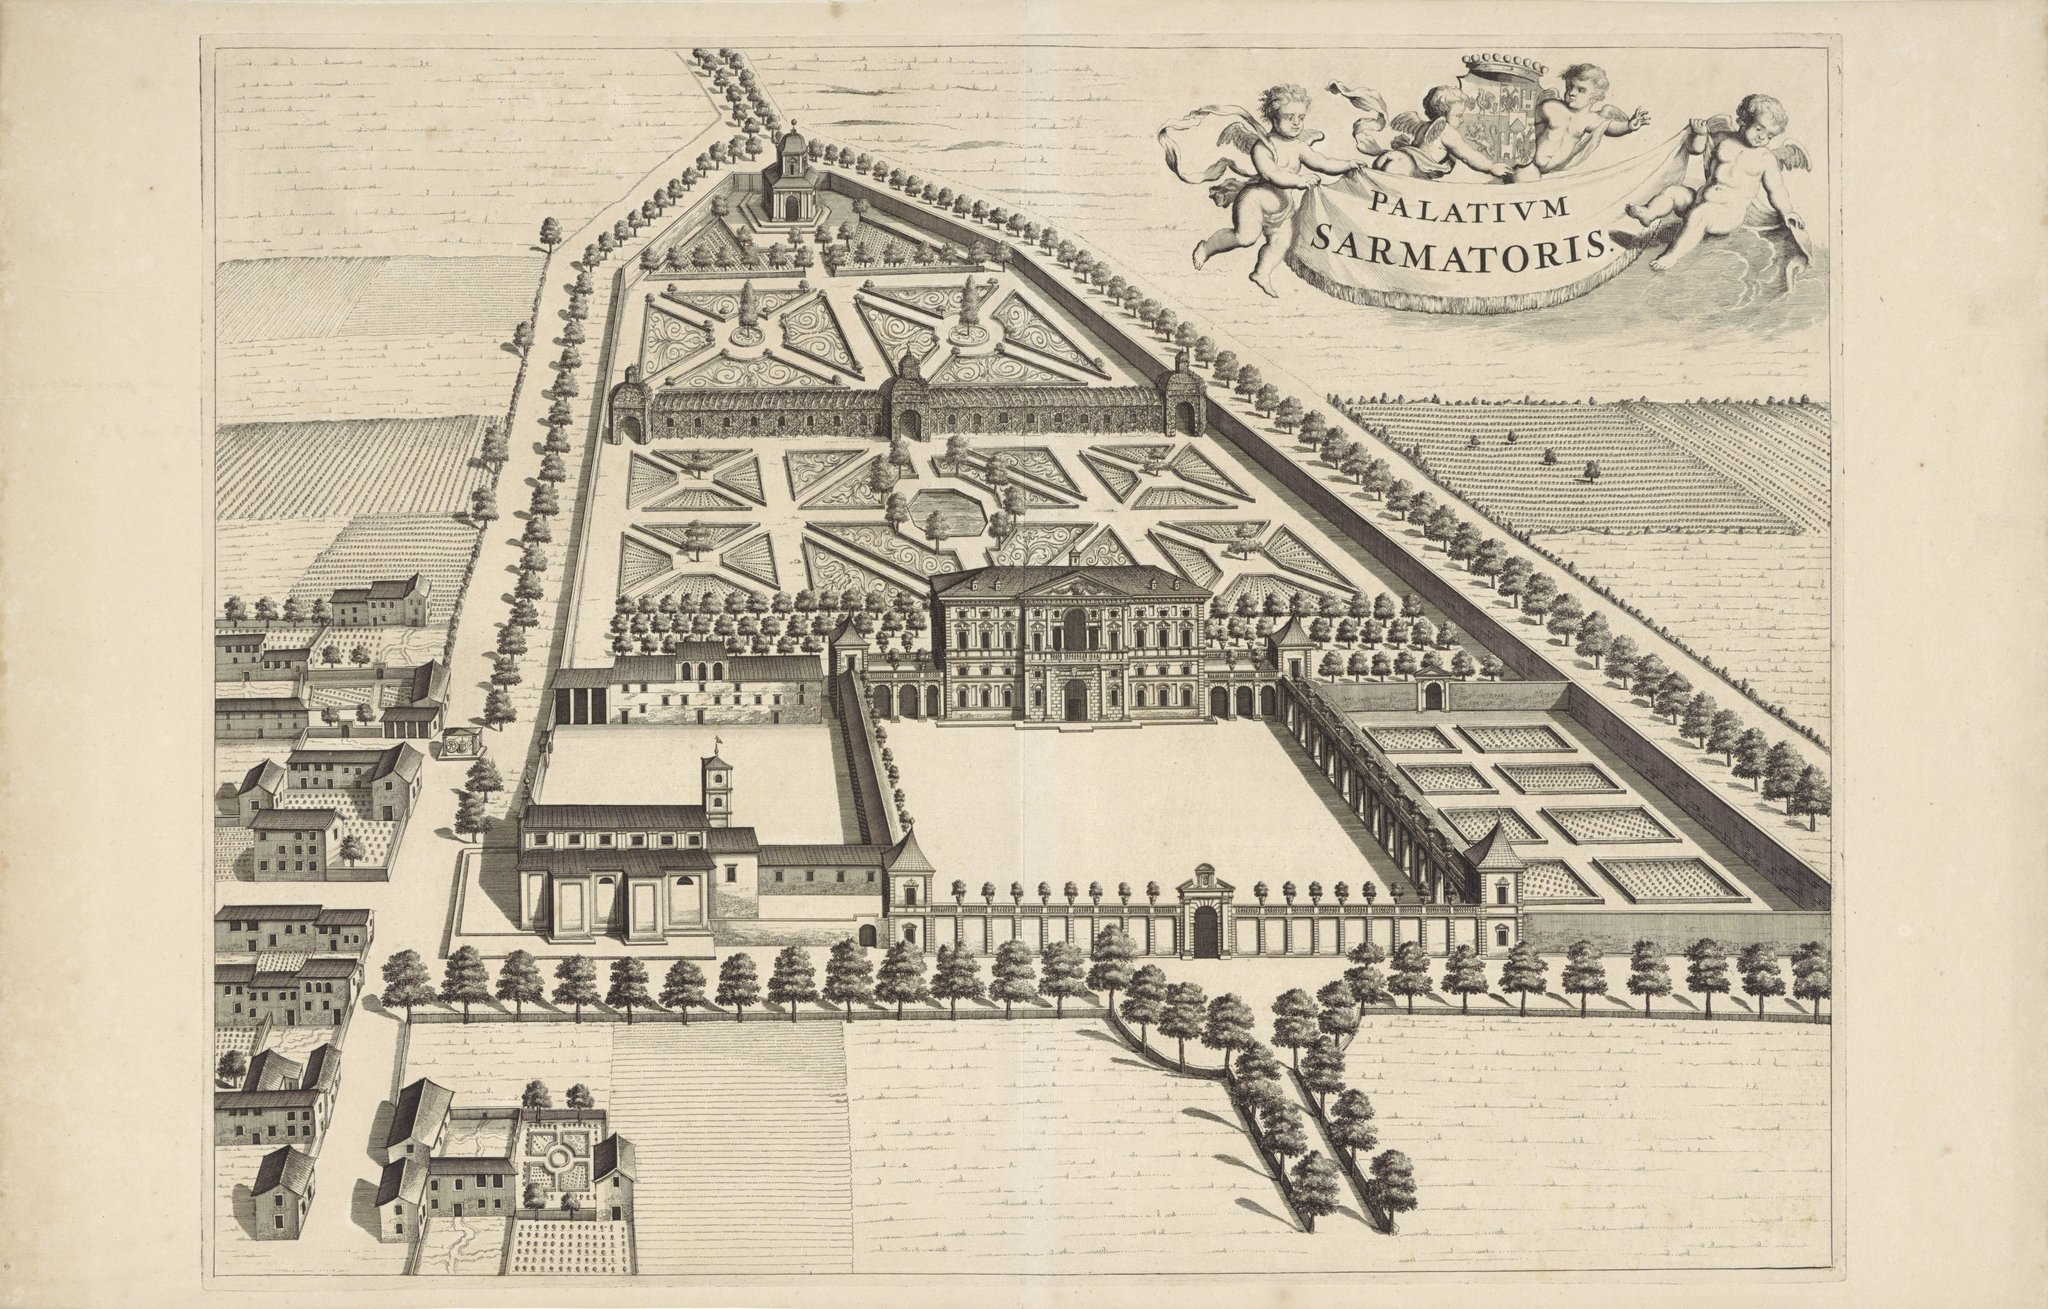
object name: print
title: Palativm Sarmatoris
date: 1725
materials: paper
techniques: etching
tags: rural housing, e.g. country-house, villa, cottage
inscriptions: collector's mark: Lugt 2228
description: Gezicht vanuit vogelperspectief op een buitenverblijf. Rechtsboven dragen putti een gekroond familiewapen en de titel van de prent.